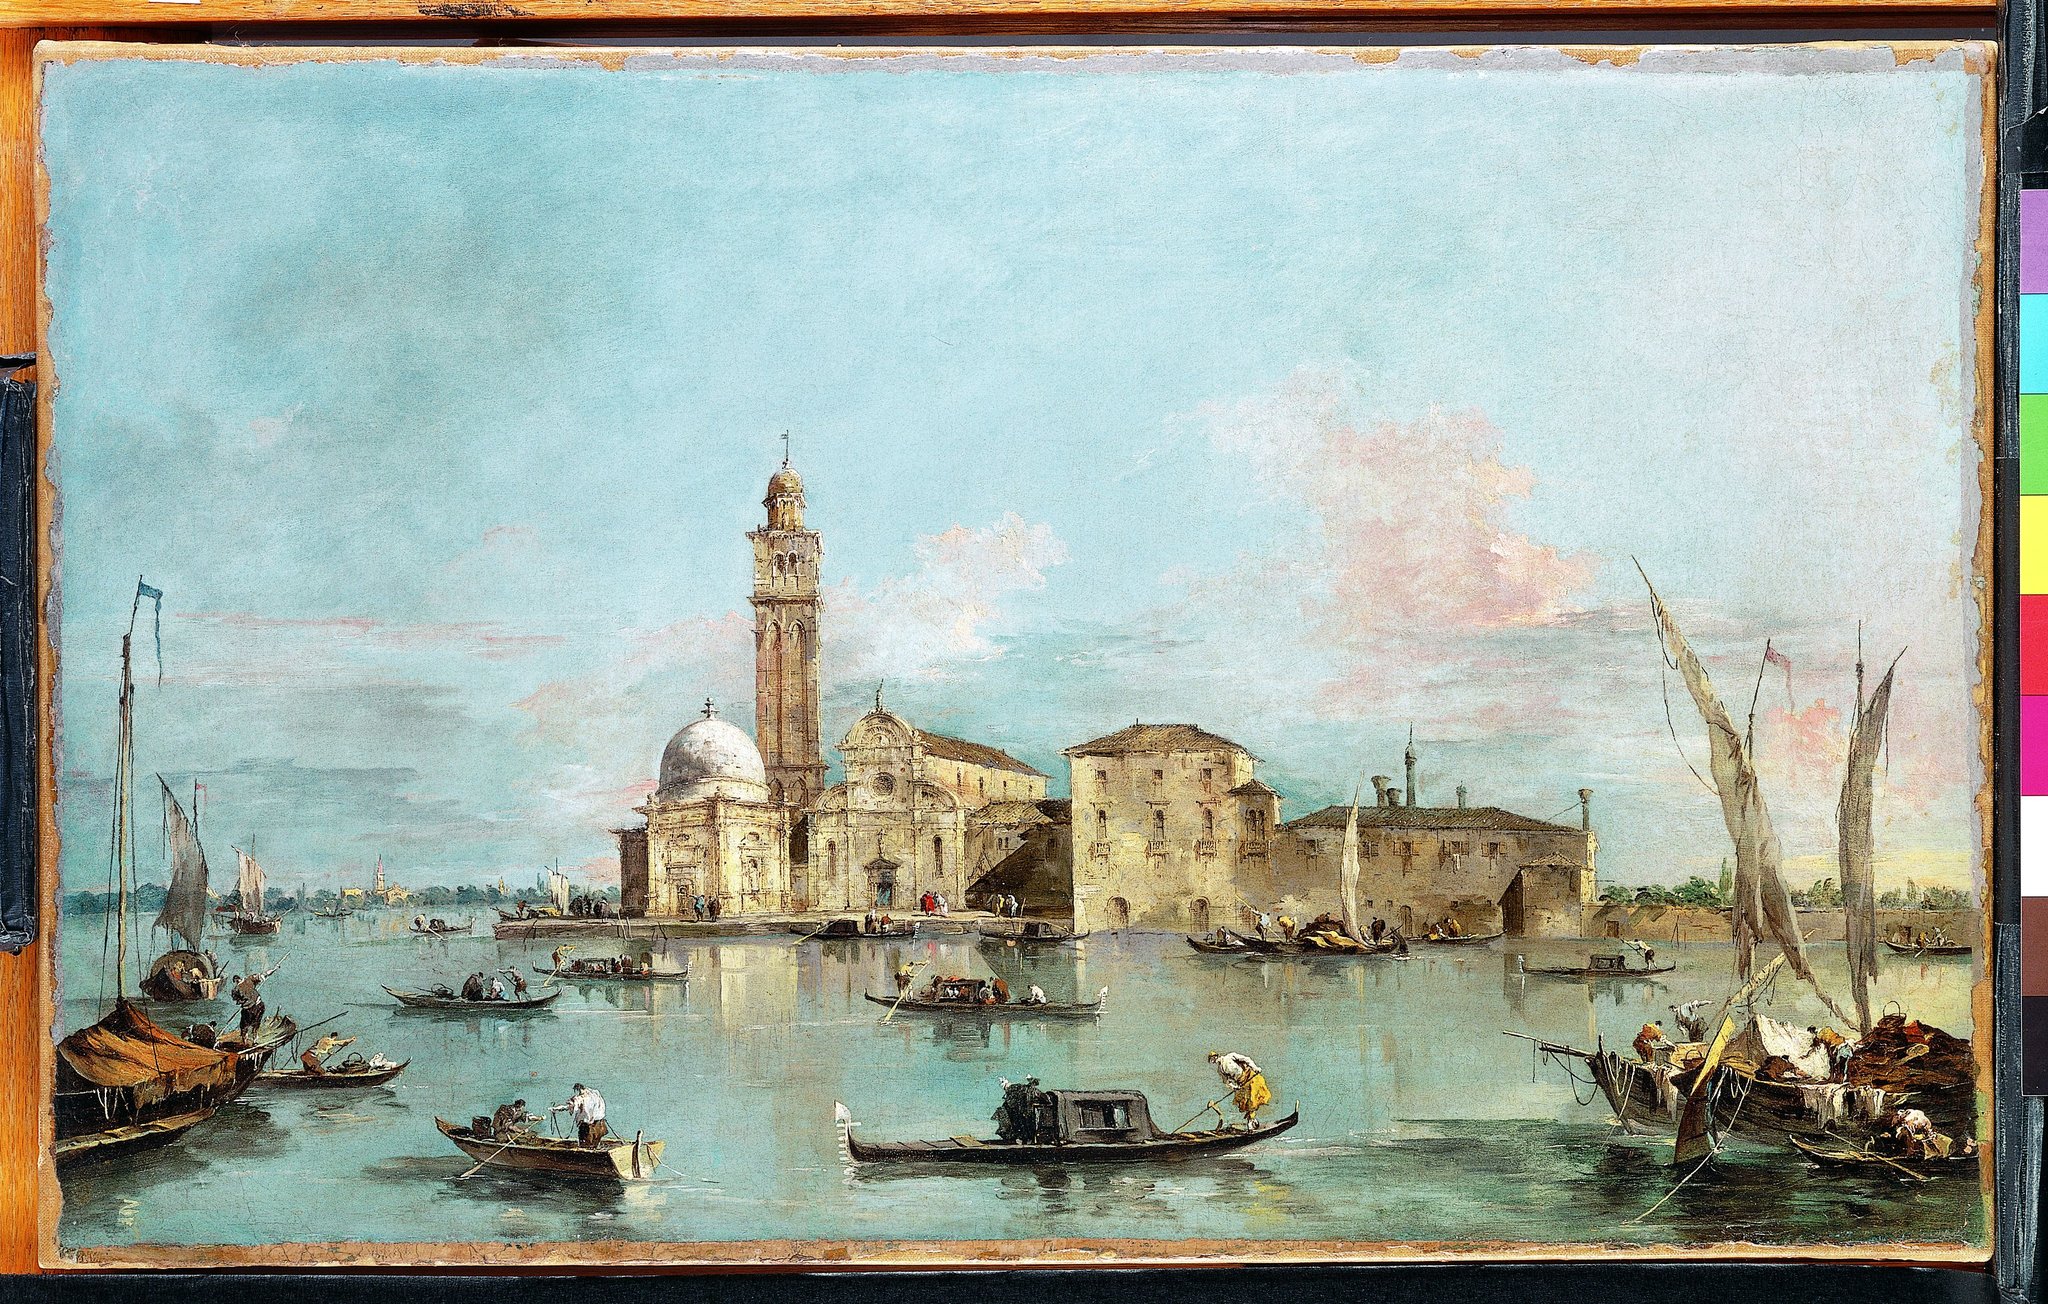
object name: painting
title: The Island of San Michele, Venice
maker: francesco guardi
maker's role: artist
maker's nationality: italian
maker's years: 1712-1793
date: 1770-1779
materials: canvas, oil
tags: towers,cities,boats,venice